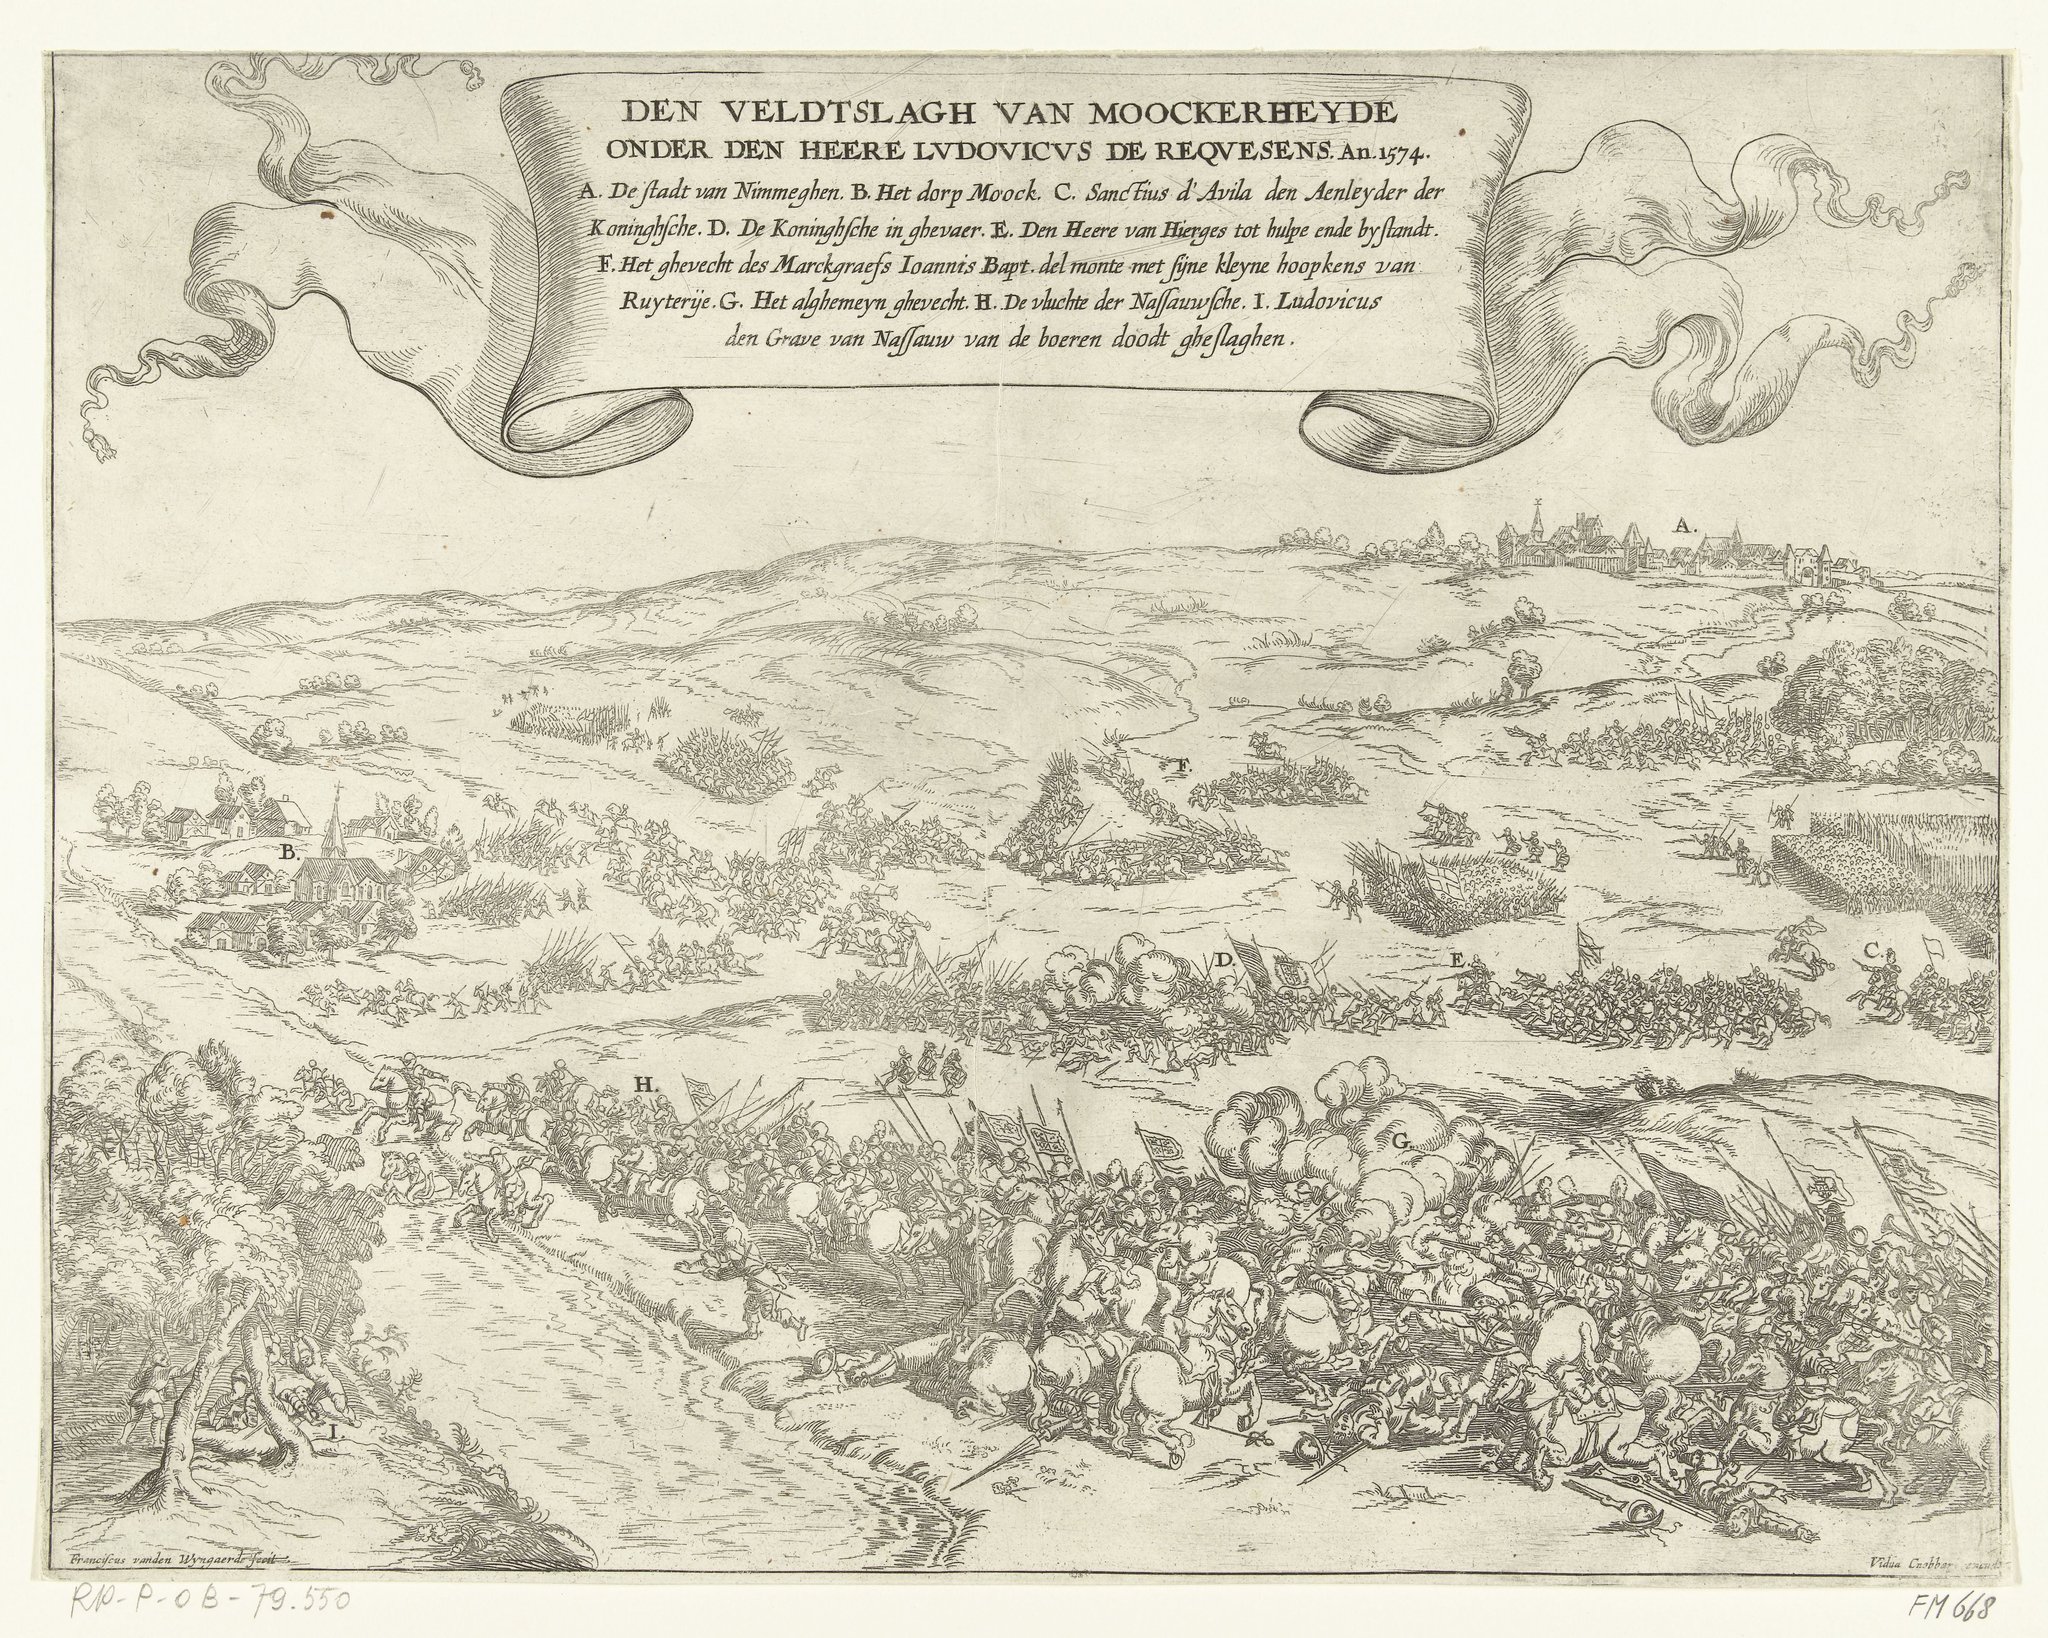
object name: print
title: Slag op de Mookerheide, 1574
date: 1643-1645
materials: paper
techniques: etching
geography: southern netherlands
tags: battle (+ land forces), nijmegen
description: Slag op de Mookerheide op 14 april 1574. Op de voorgrond en in het midden zware gevechten tussen ruiters. Links het dorpje Mook, rechts in de verte Nijmegen. Bovenin een banderol met de titel en legenda A-I in het Nederlands.